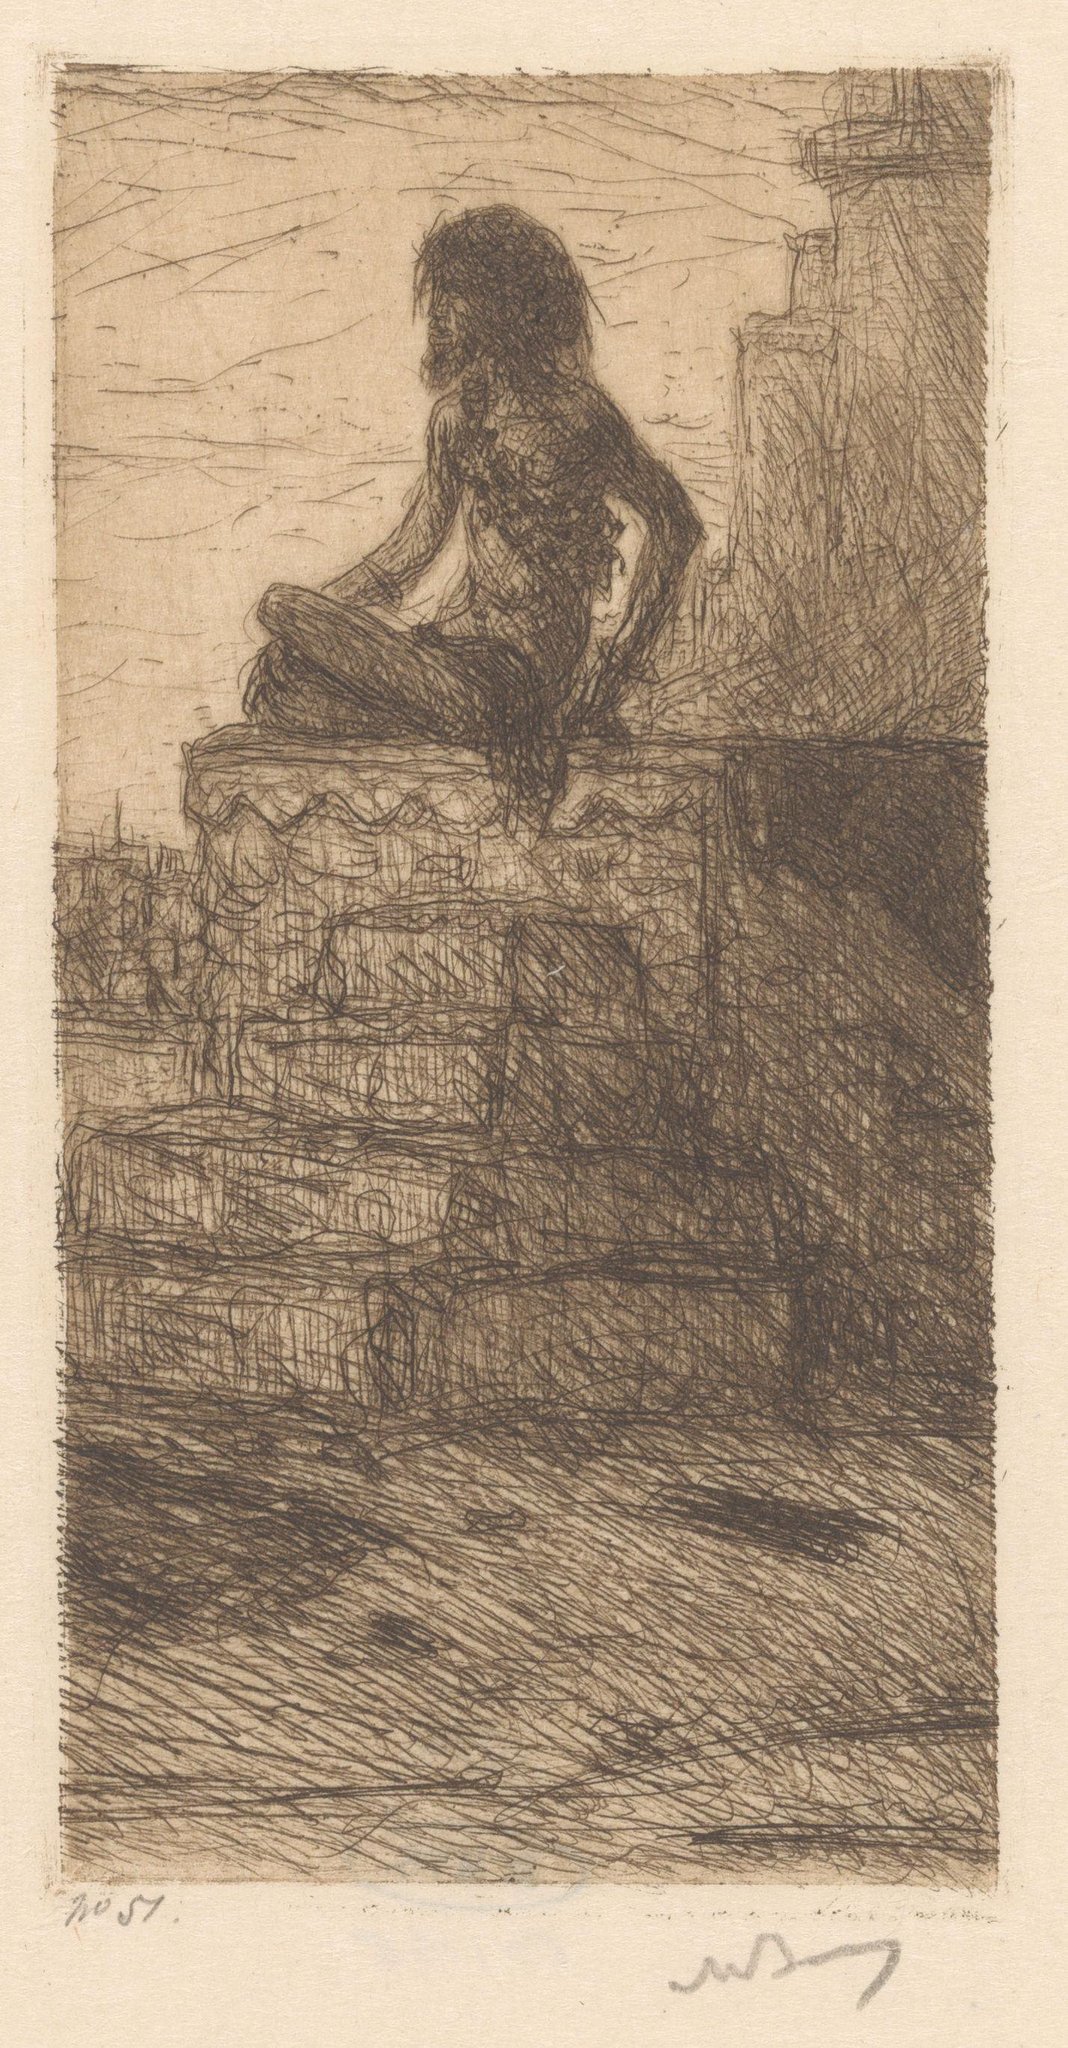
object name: print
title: Fakir in Benares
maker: marius bauer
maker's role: draughtsman, print maker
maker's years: 1867-1932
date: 1926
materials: paper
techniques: etching, intaglio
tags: asceticism ~ hinduism, buddhism, jainism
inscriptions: collector's mark: Lugt 2228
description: Een halfnaakte man in kleermakerszit op een muur.